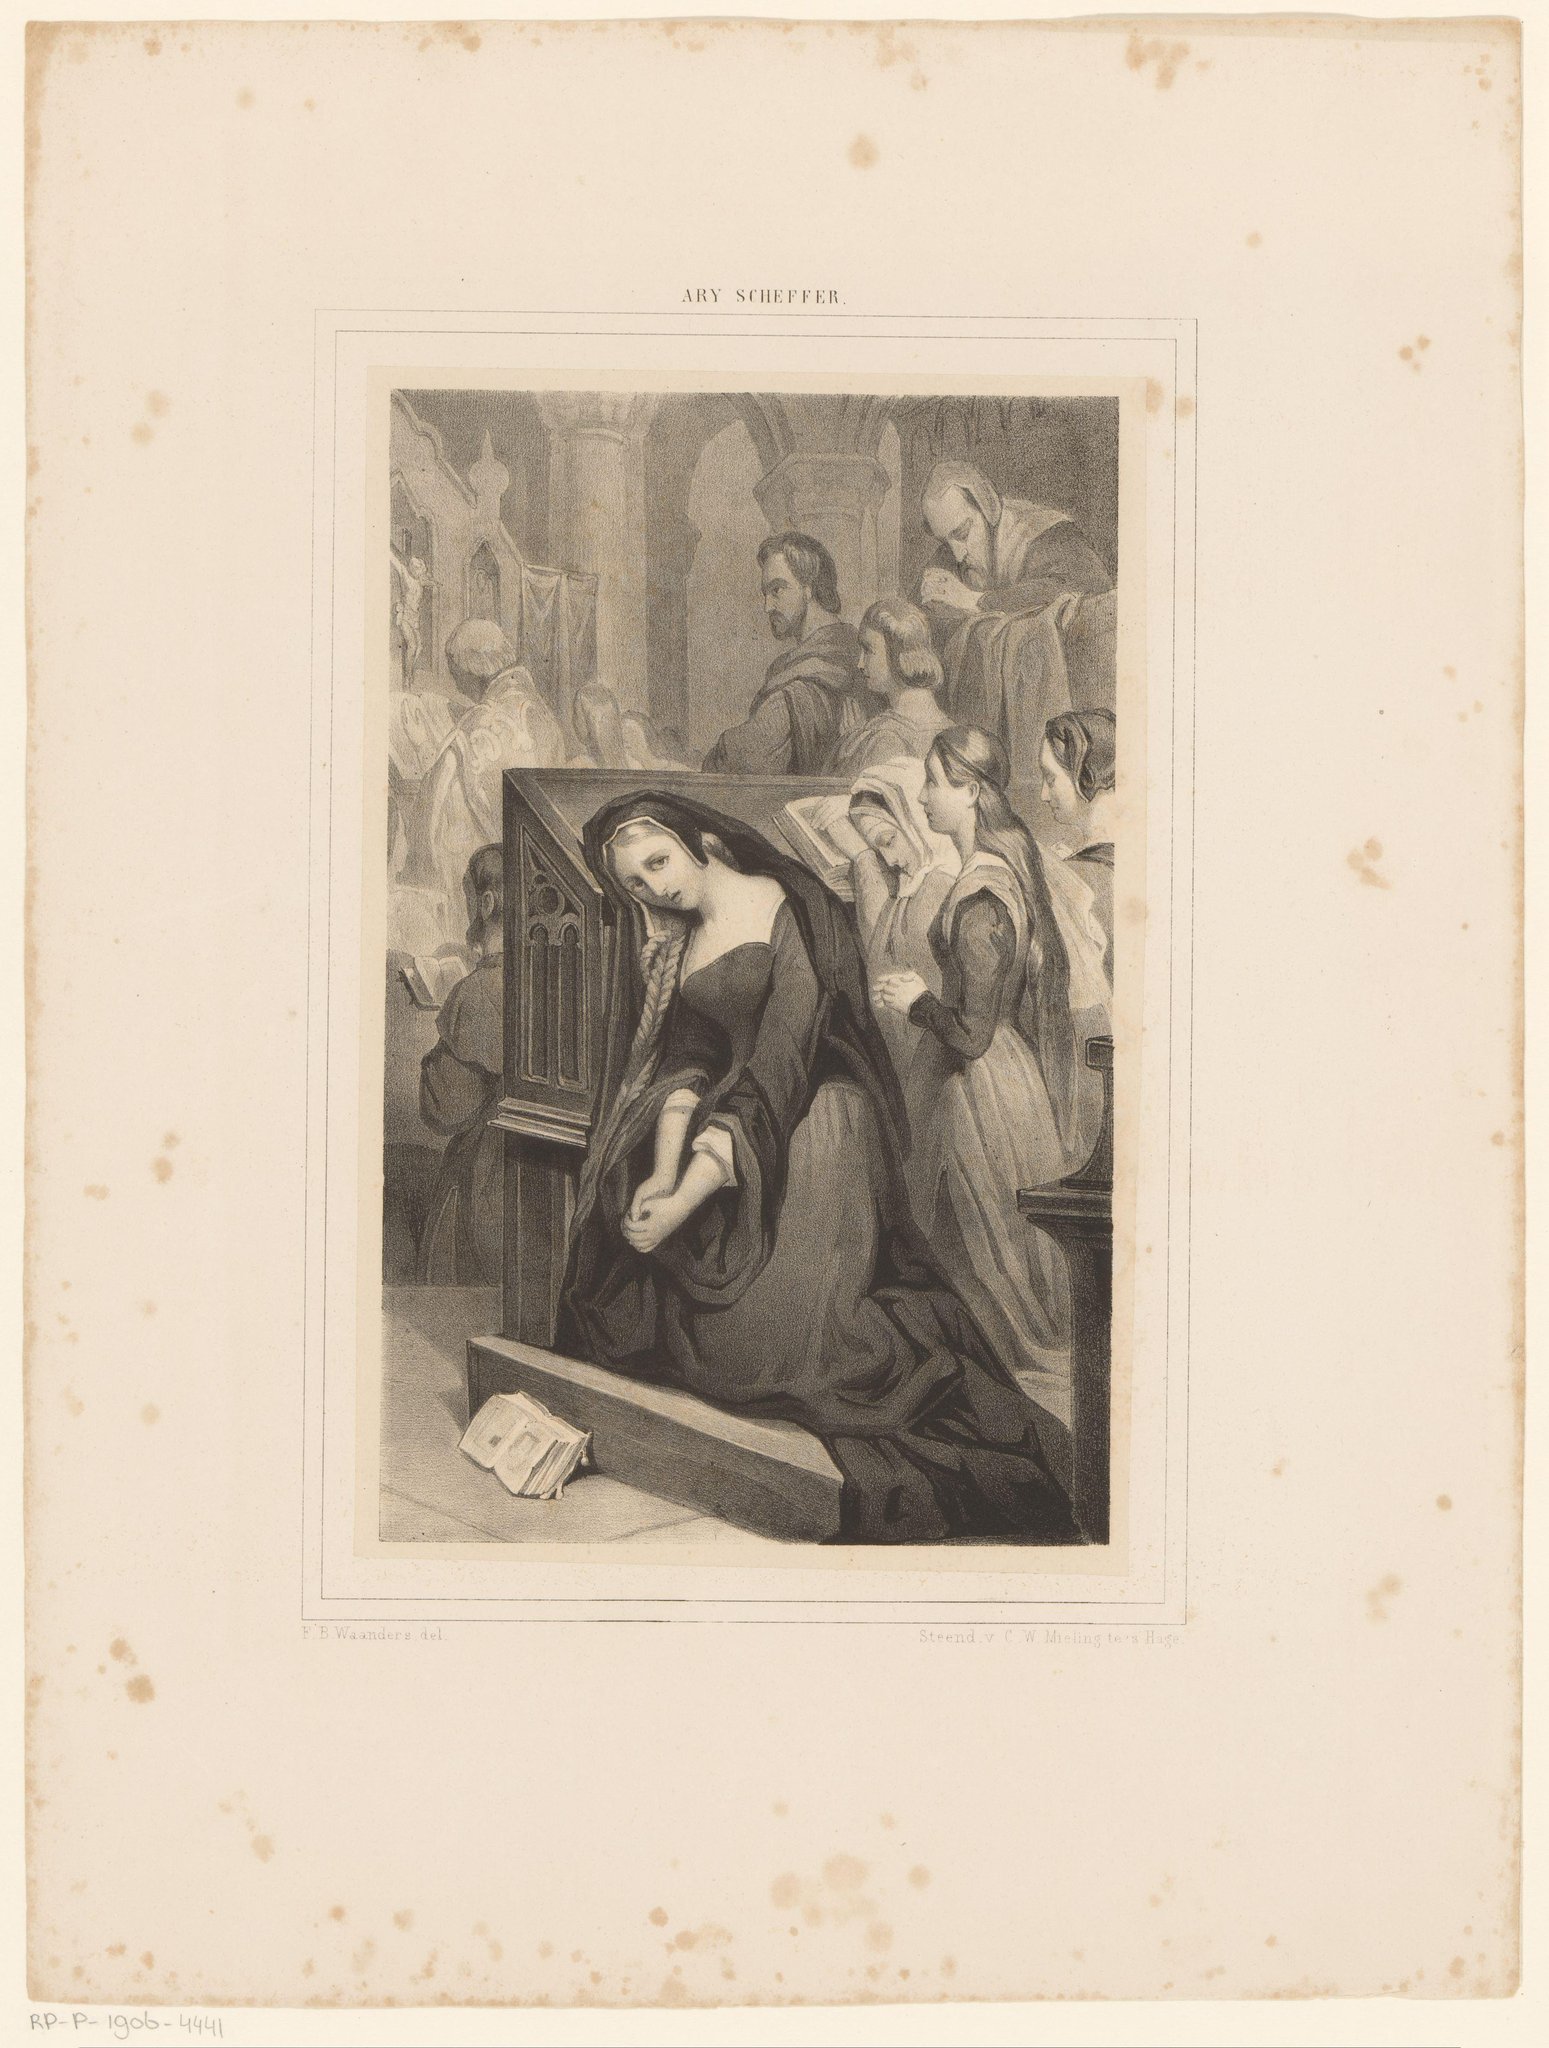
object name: print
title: Boetvaardig Margaretha in de kerk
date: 1846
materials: paper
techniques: lithograph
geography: the hague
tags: the franciscan tertiary margaret of cortona; possible attributes: discipline, dog, lily, skull, stone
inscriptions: collector's mark: Lugt 2228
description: Margaretha van Cortona als boeteling zit geknield voor een kerkbank. Achter haar zitten geknielde jonge vrouwen.